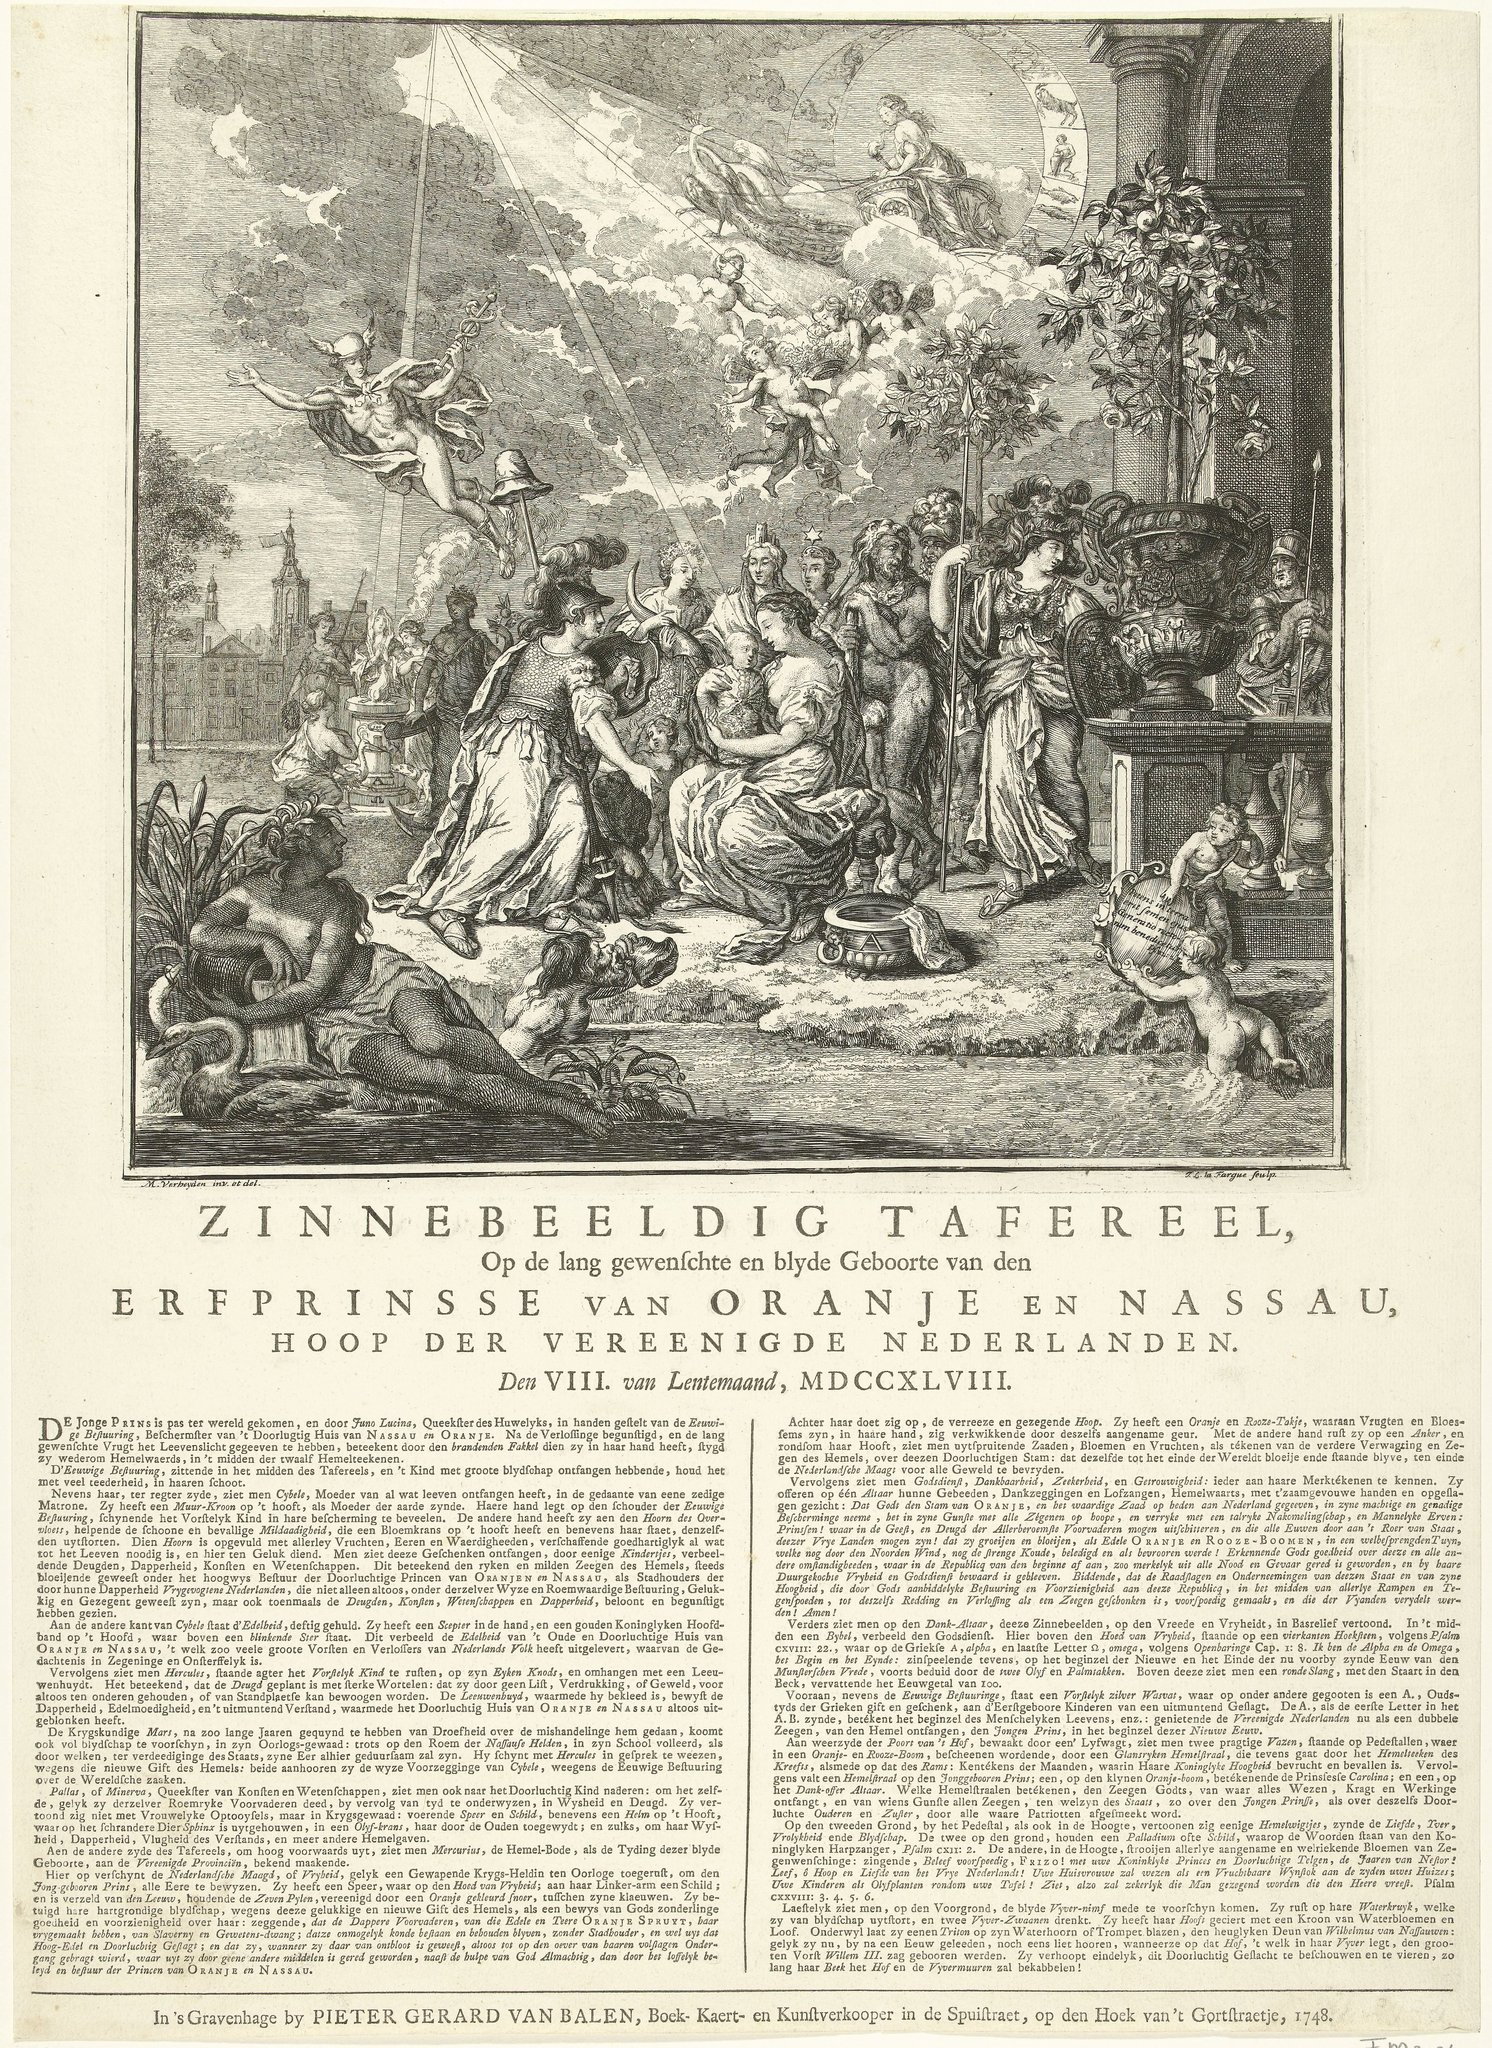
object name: print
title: Allegorie op de geboorte van de prins van Oranje, 1748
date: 1748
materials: paper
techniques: engraving, etching, letterpress printing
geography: northern netherlands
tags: the hague, william v (prince of orange)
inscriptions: signature: ‘M.Verheyden inv. et del.’, signature: ‘J.L. la Fargue Sculp.’, collector's mark: Lugt 2228, signature: ‘In 's Gravenhage by PIETER GERARD VAN BALEN,....Hoek van Gortstraetje, 1748.’, caption: ‘ZINNEBEELDIG TAFEREEL/Op de lang gewenschte.../...NEDERLANDEN./Den VIII. van Lentemaand, MDCCXLVIII./ De jonge PRINS.../.../...zal bekabbelen!’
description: Allegorie op de geboorte van Willem V, prins van Oranje, 8 maart 1748. Centraal de personificatie Eeuwige Besturing met het kind in de armen, omringd door alllerlei allegorische figuren, goden en godinnen, links de Nederlandse Maagd. Rechts groeien verstrengeld in een vaas de Oranjeboom en de Engelse roos. In de lucht Mercurius en Juno in haar strijdwagen getrokken door pauwen bij de tekens van de dierenriem. Op de voorgrond links de nimf van de Hofvijver, op de achtergrond het stadhouderlijk kwartier te Den Haag. Op het blad onder de plaat een uitleg van de voorstelling in twee kolommen.